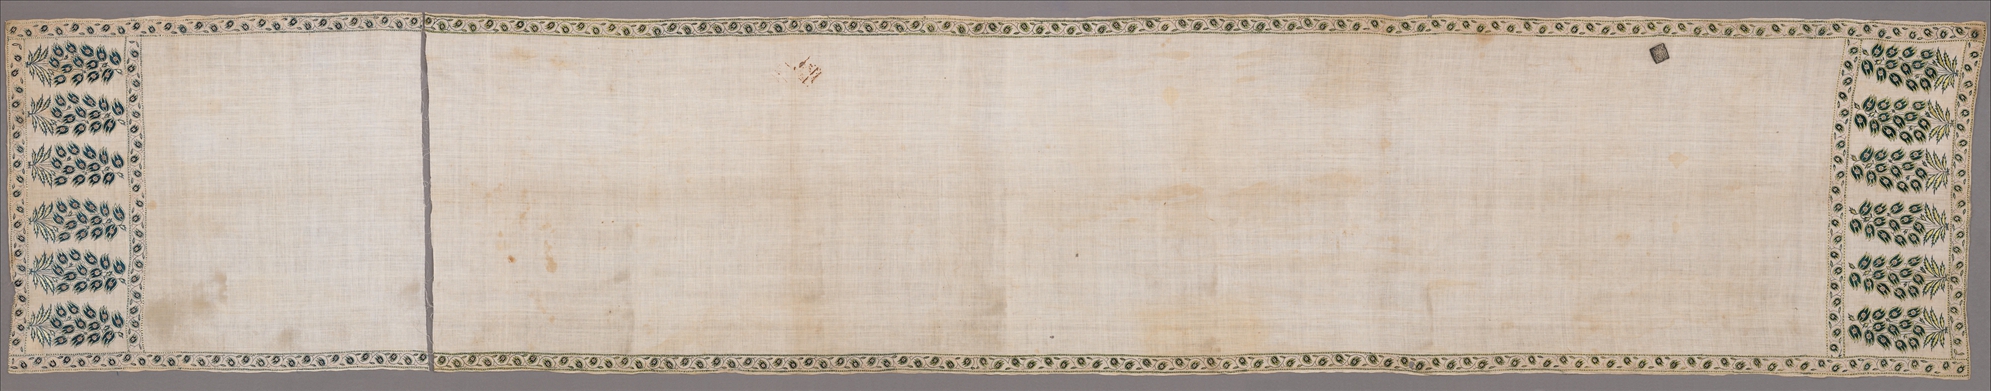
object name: sash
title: Sash (Patka)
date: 1667-1700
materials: cotton, silk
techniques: embroidery, weave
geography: india